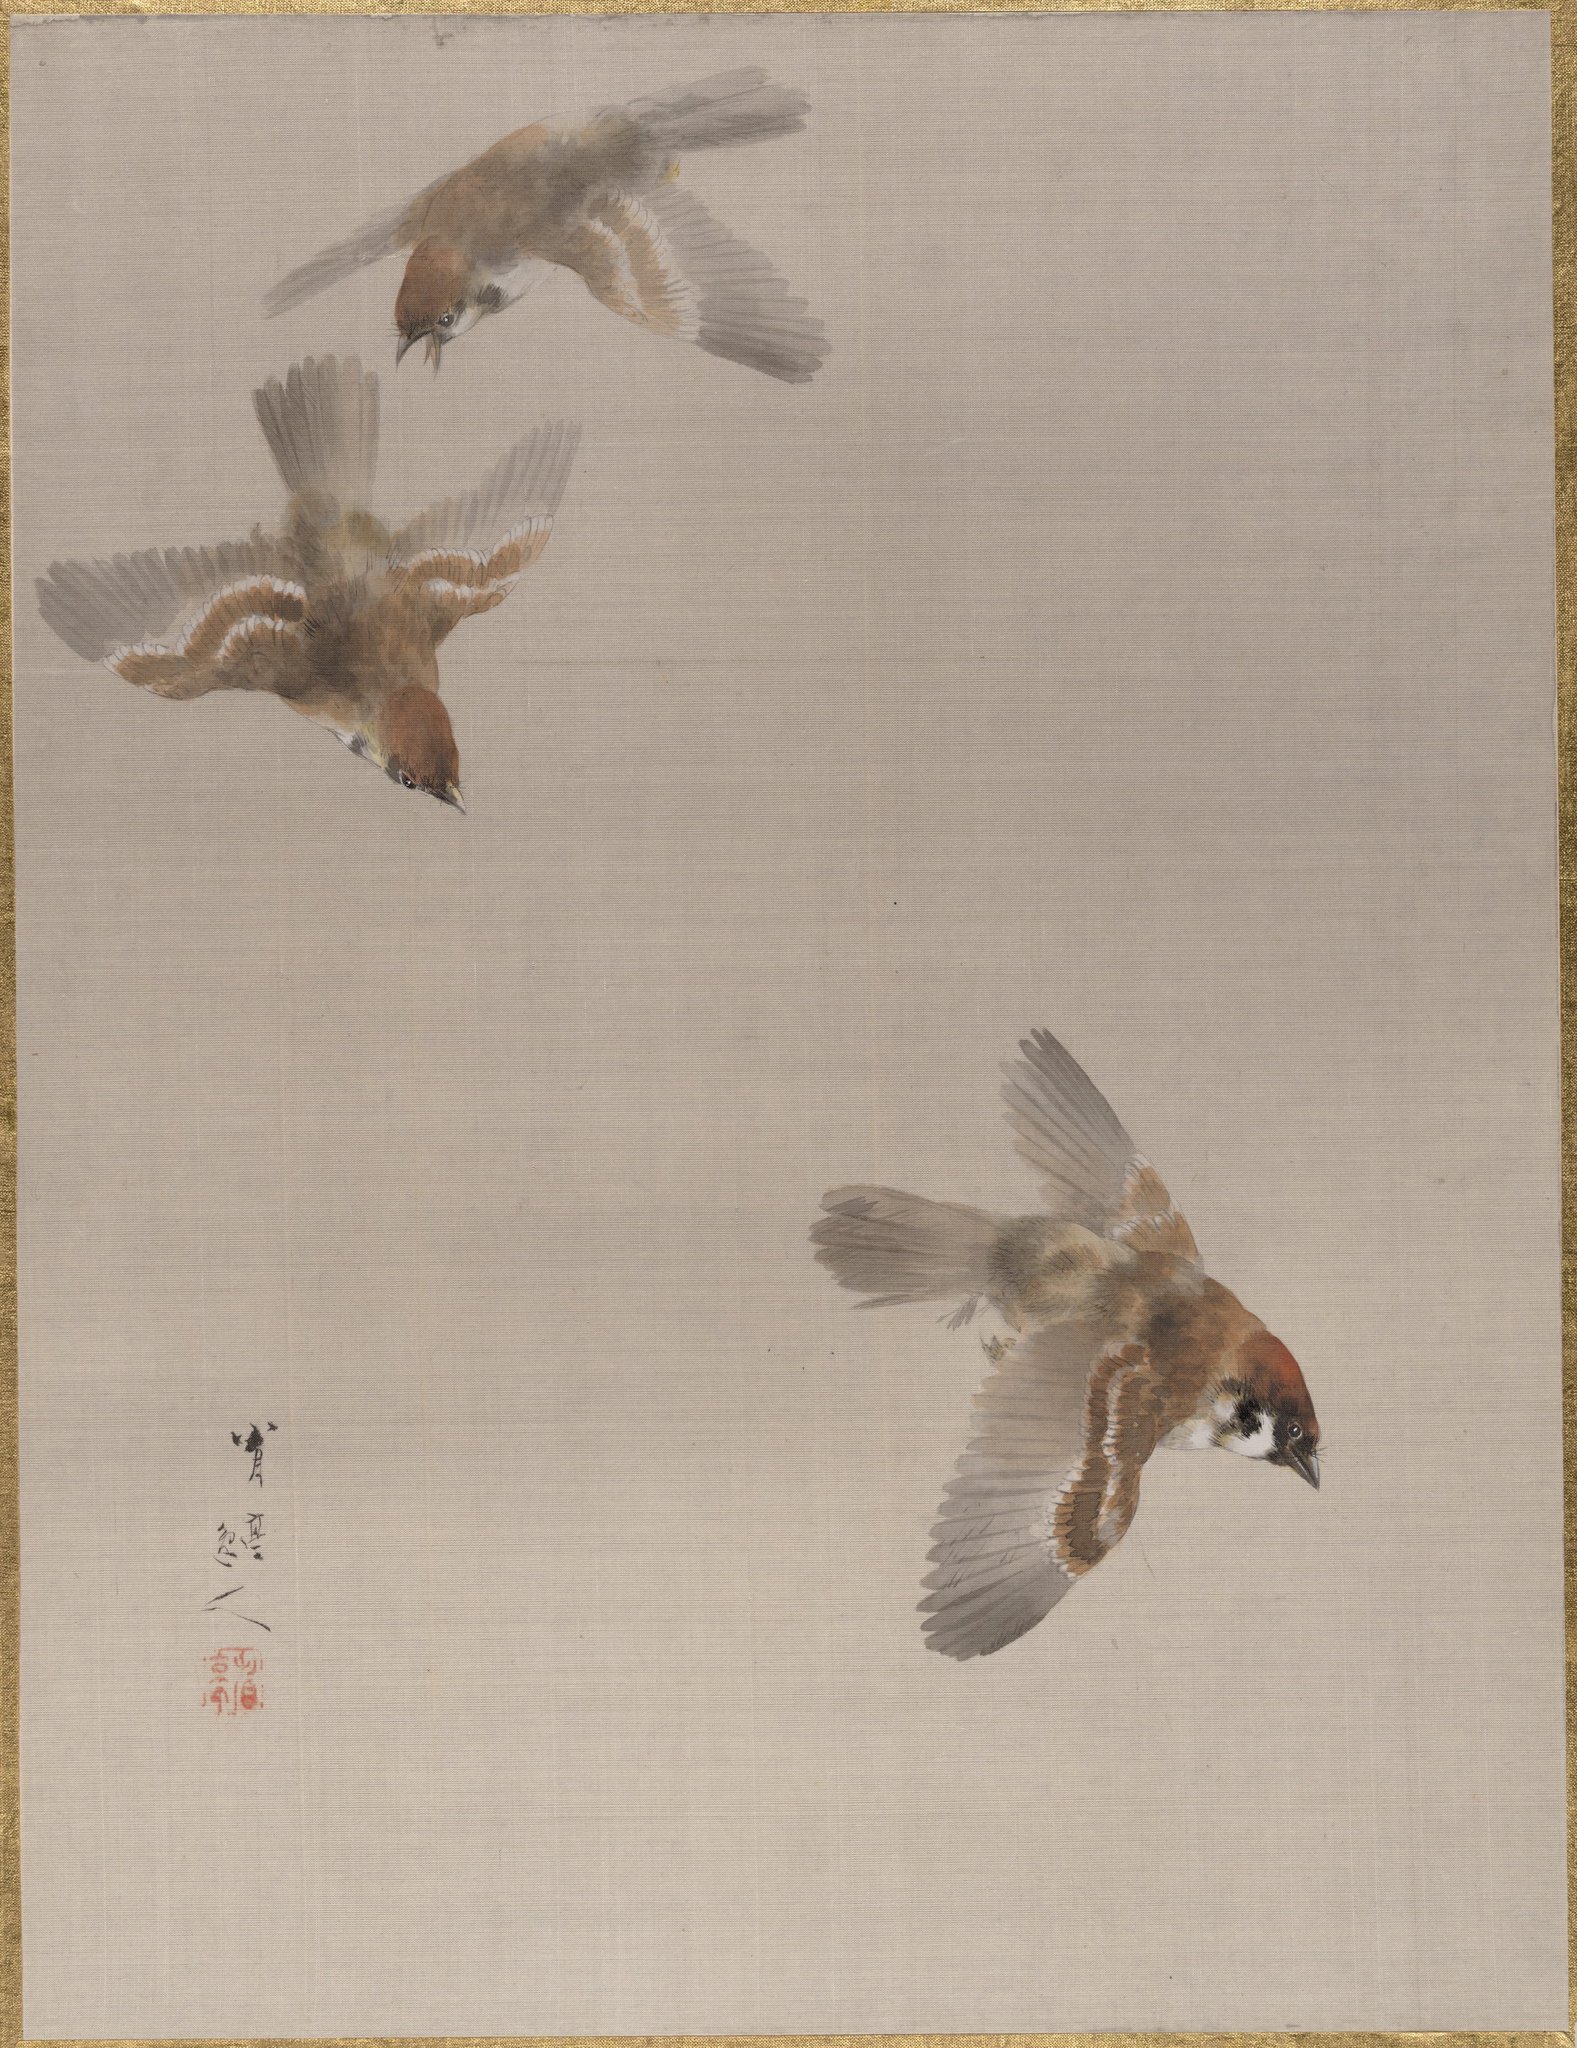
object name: album leaf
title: Sparrows Flying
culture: japanese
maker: watanabe seitei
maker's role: artist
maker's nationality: japanese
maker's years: 1851-1918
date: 1887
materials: ink, silk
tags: birds